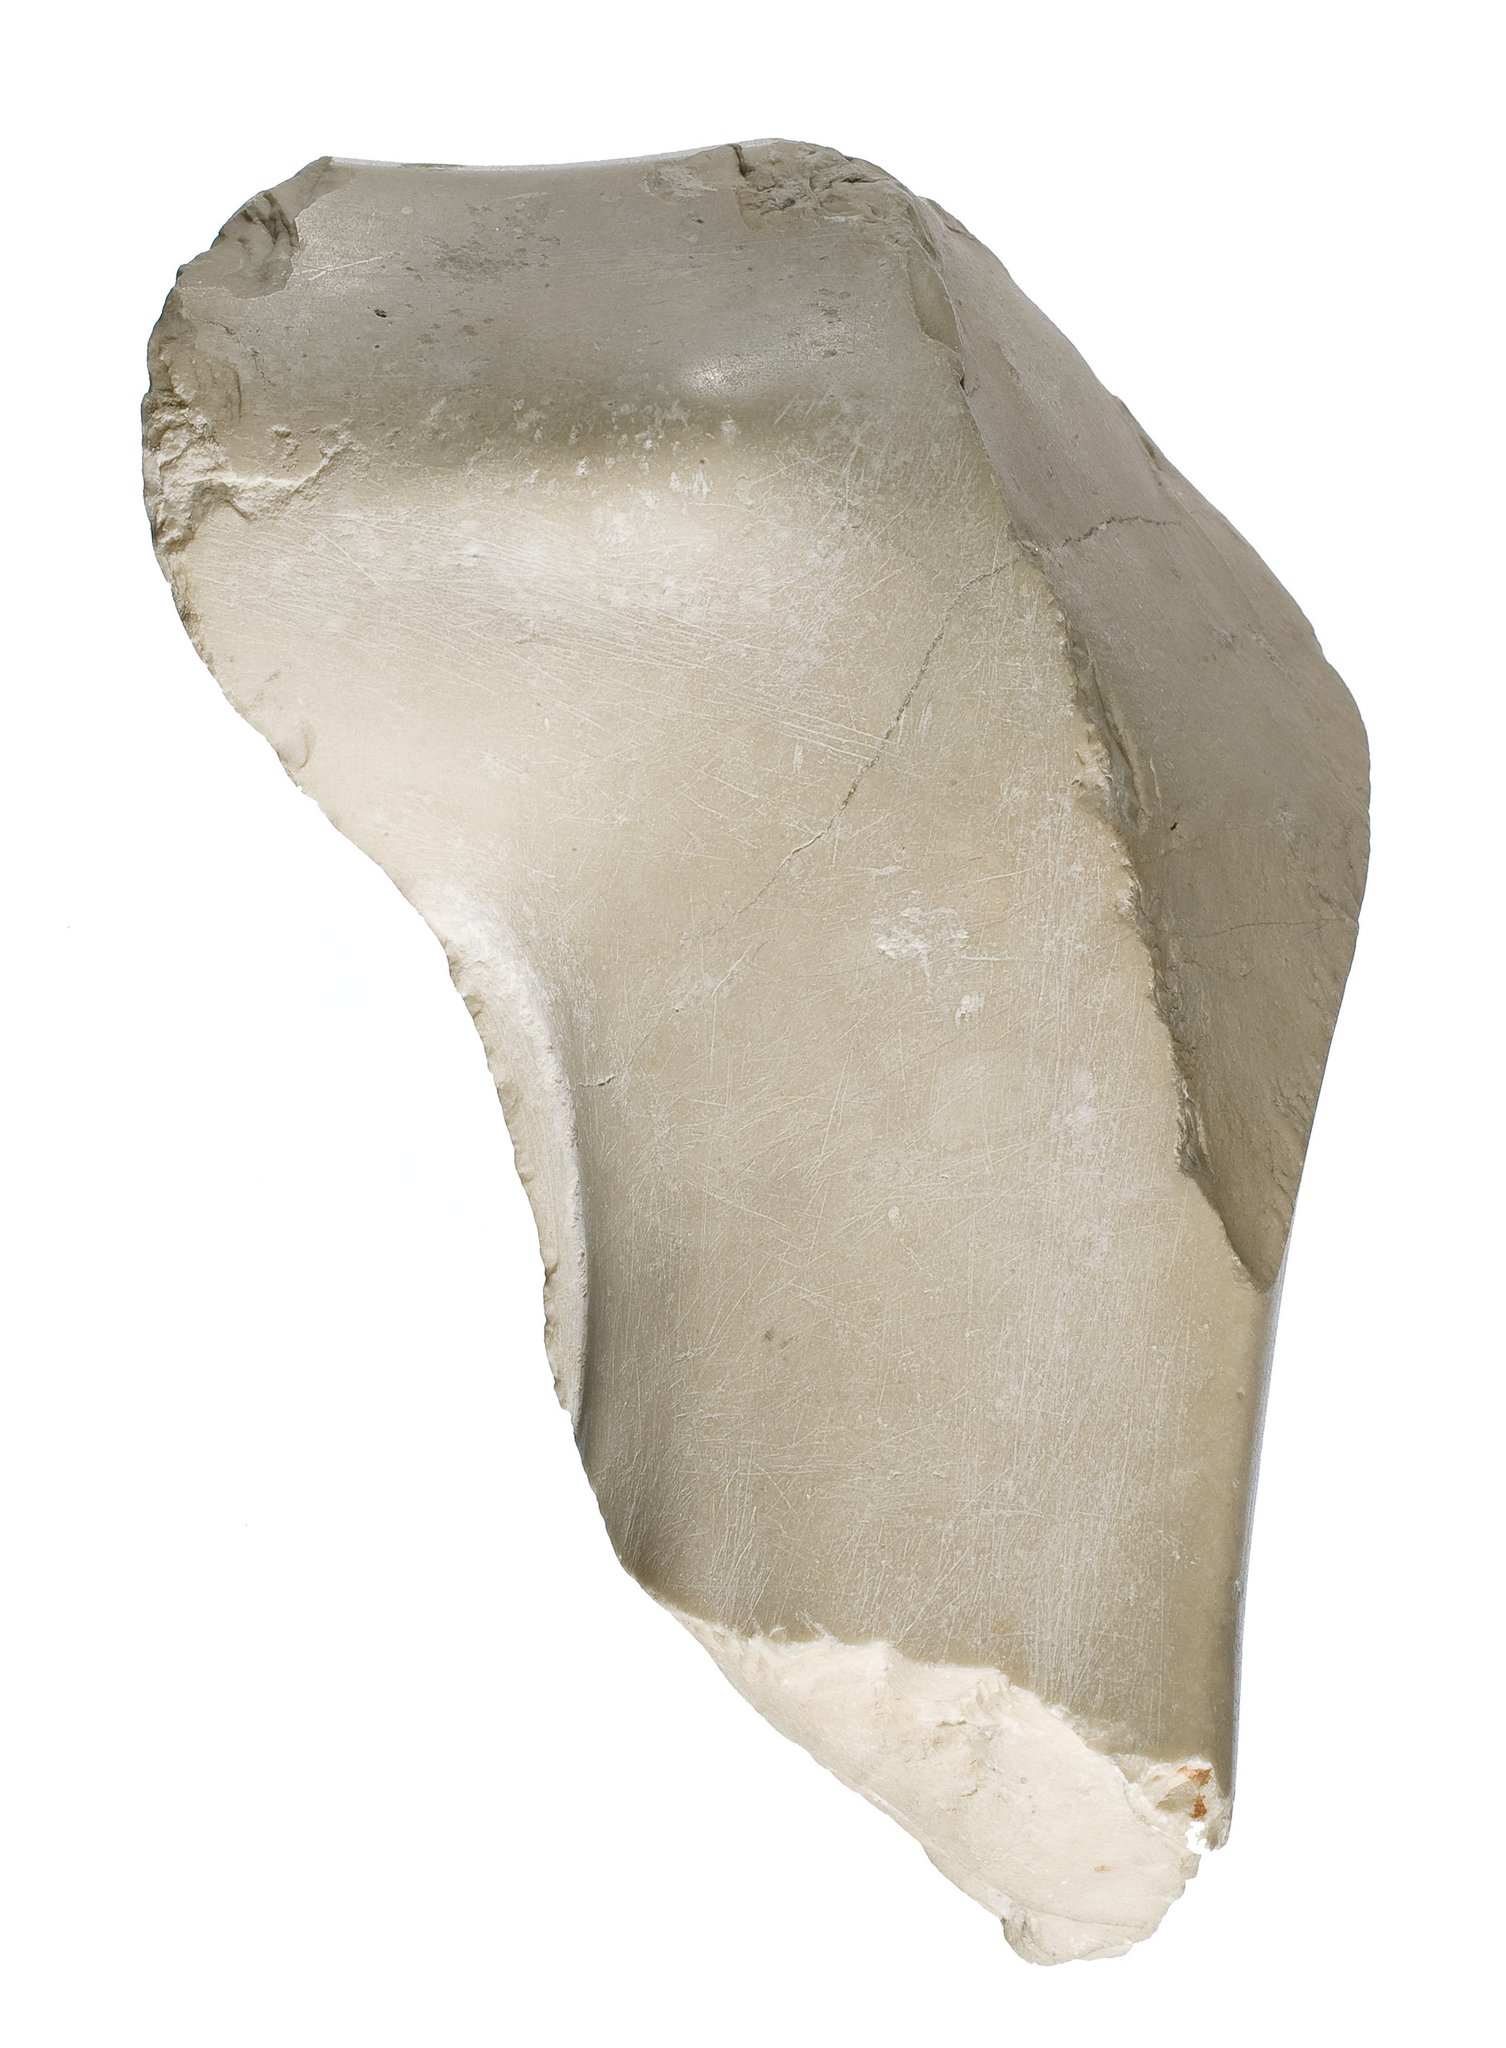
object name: akhenaten or nefertiti prostrate, foot leg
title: Foot and leg of Akhenaten or Nefertiti prostrate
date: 1352-1336 BCE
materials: limestone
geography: egypt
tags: nefertiti,feet